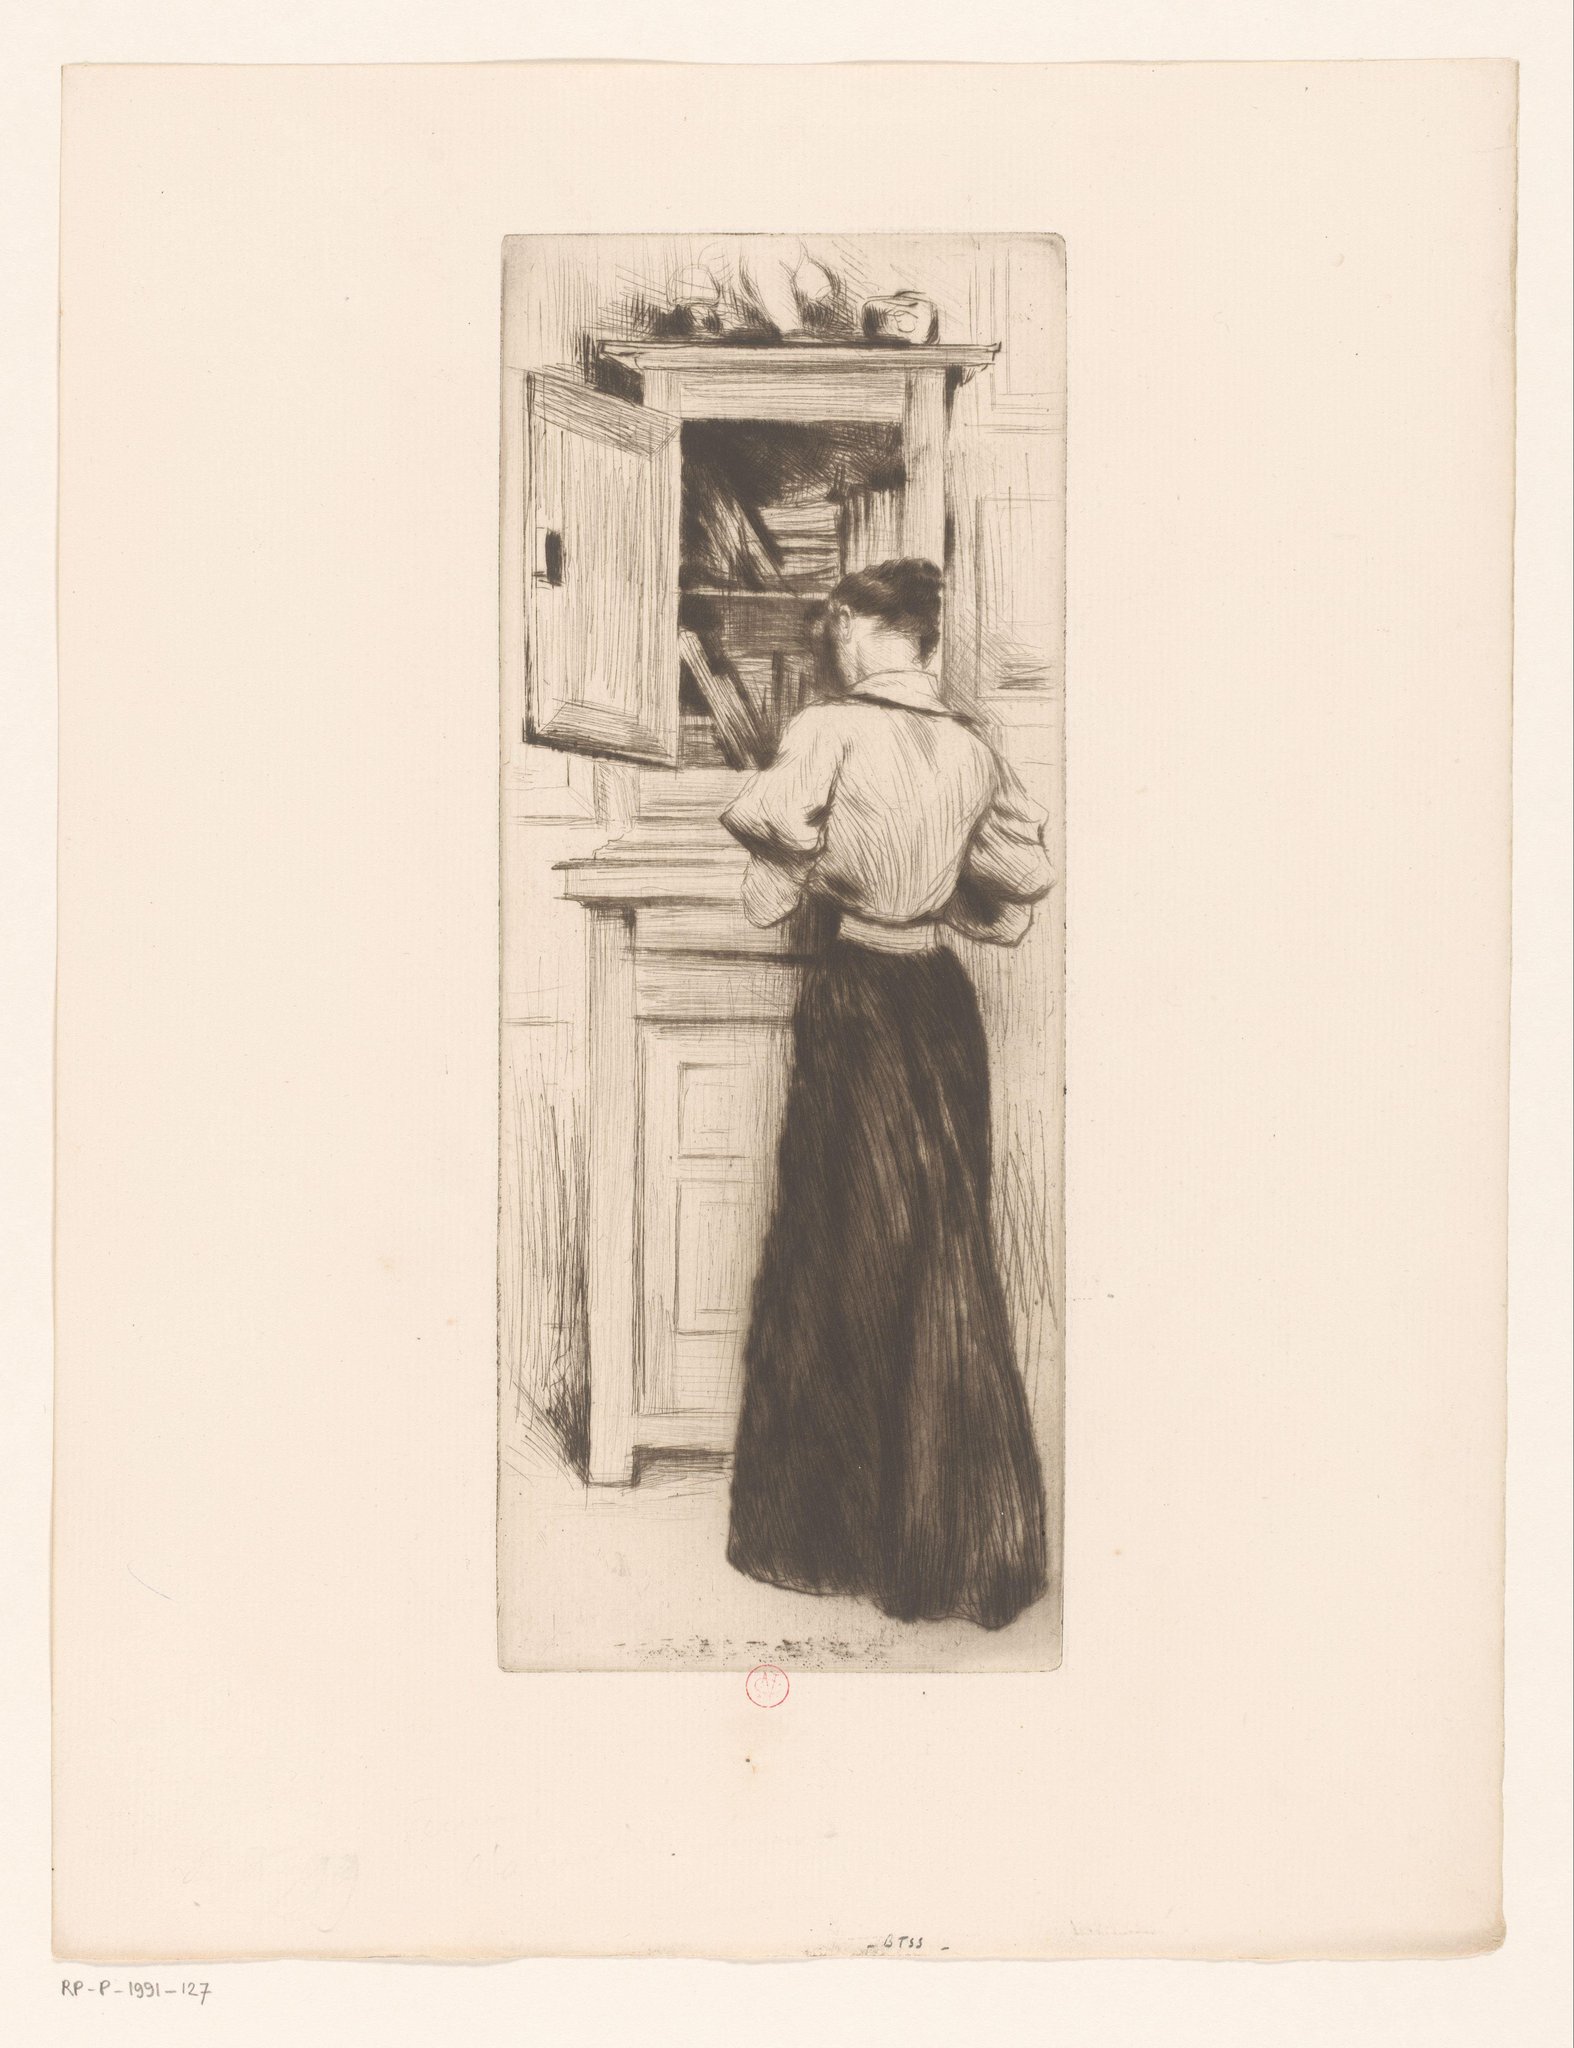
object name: print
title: Portret van Suzanne Froliger bij een kast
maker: norbert goeneutte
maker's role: draughtsman, painter, print maker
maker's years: 1854-1894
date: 1891-1894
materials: paper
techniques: drypoint, etching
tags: historical persons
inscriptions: stamp: Lugt 1182, collector's mark: Lugt 2228, collector's mark: Lugt 2760